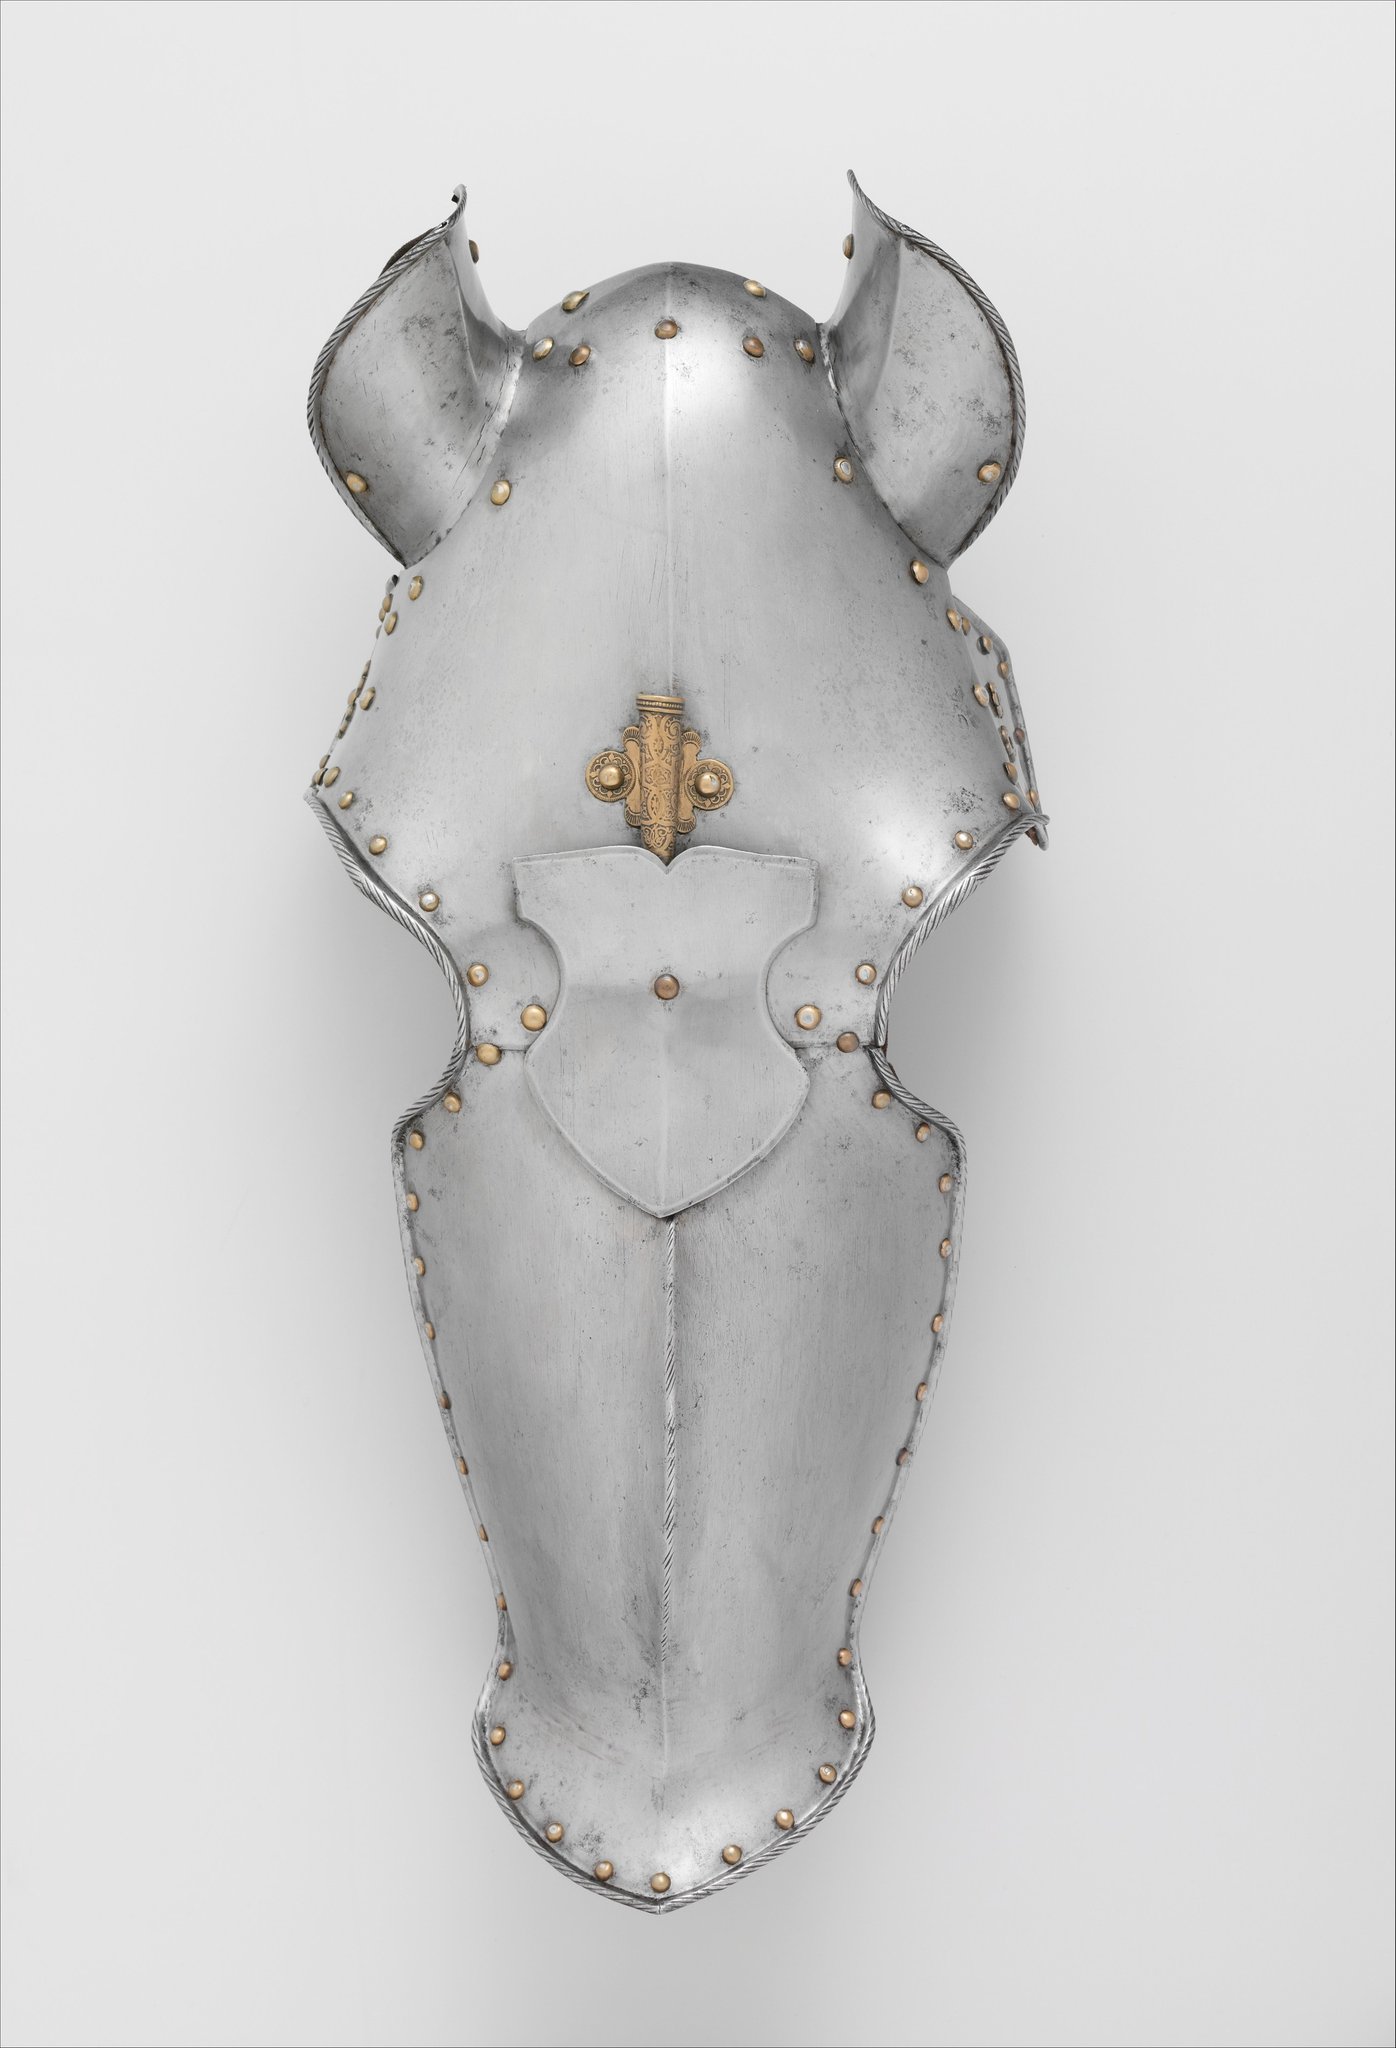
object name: shaffron horse's head defense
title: Shaffron (Horse's Head Defense)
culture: german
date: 1570-1580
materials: copper alloy, gold, leather, steel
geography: germany